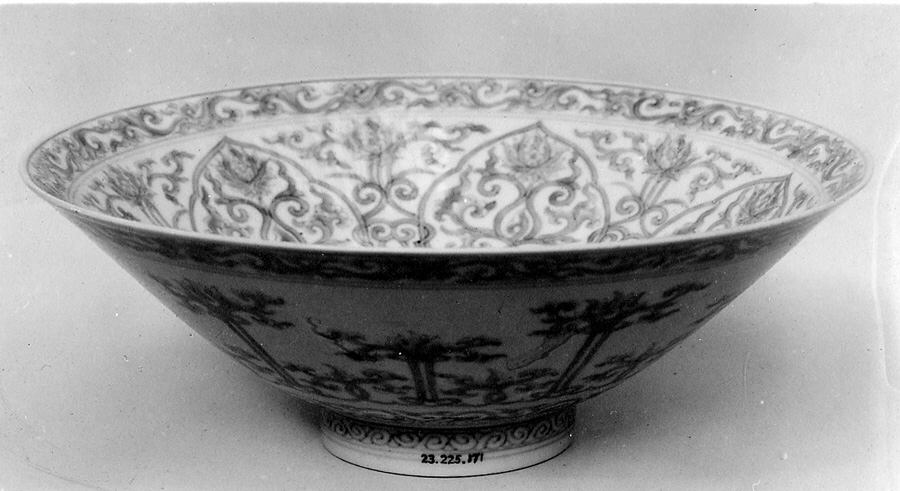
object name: bowl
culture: japanese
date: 1800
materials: glaze, porcelain